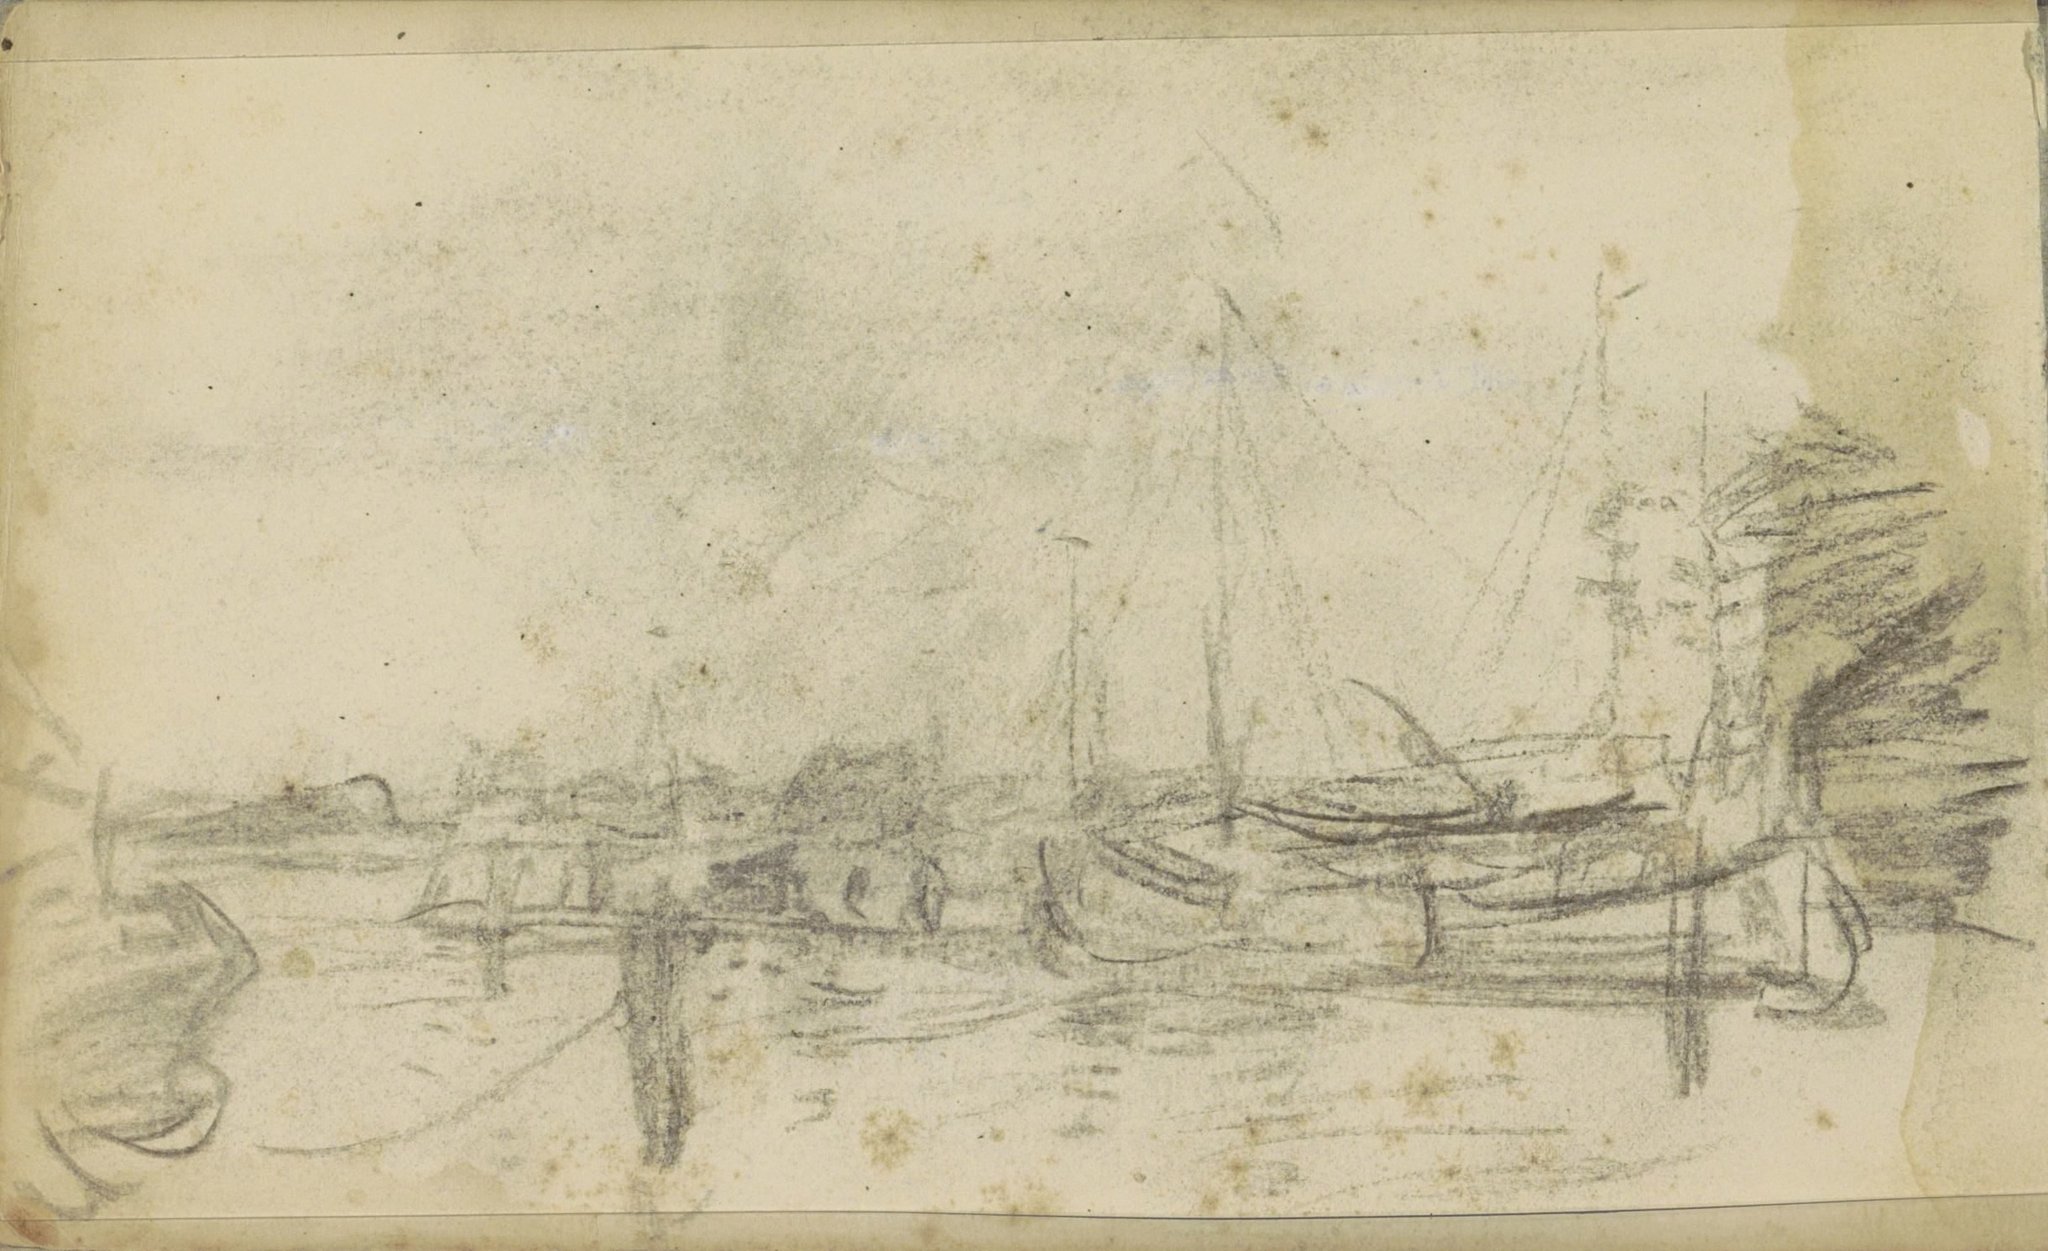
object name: sketchbook leaf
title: Zeilboten aangemeerd aan een pier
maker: jozef israëls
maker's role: draughtsman, painter, print maker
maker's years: 1824-1911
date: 1834-1911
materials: chalk, paper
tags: sailing-ship, sailing-boat, pier, quay, wharf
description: Blad 27 verso uit een schetsboek met 42 bladen.